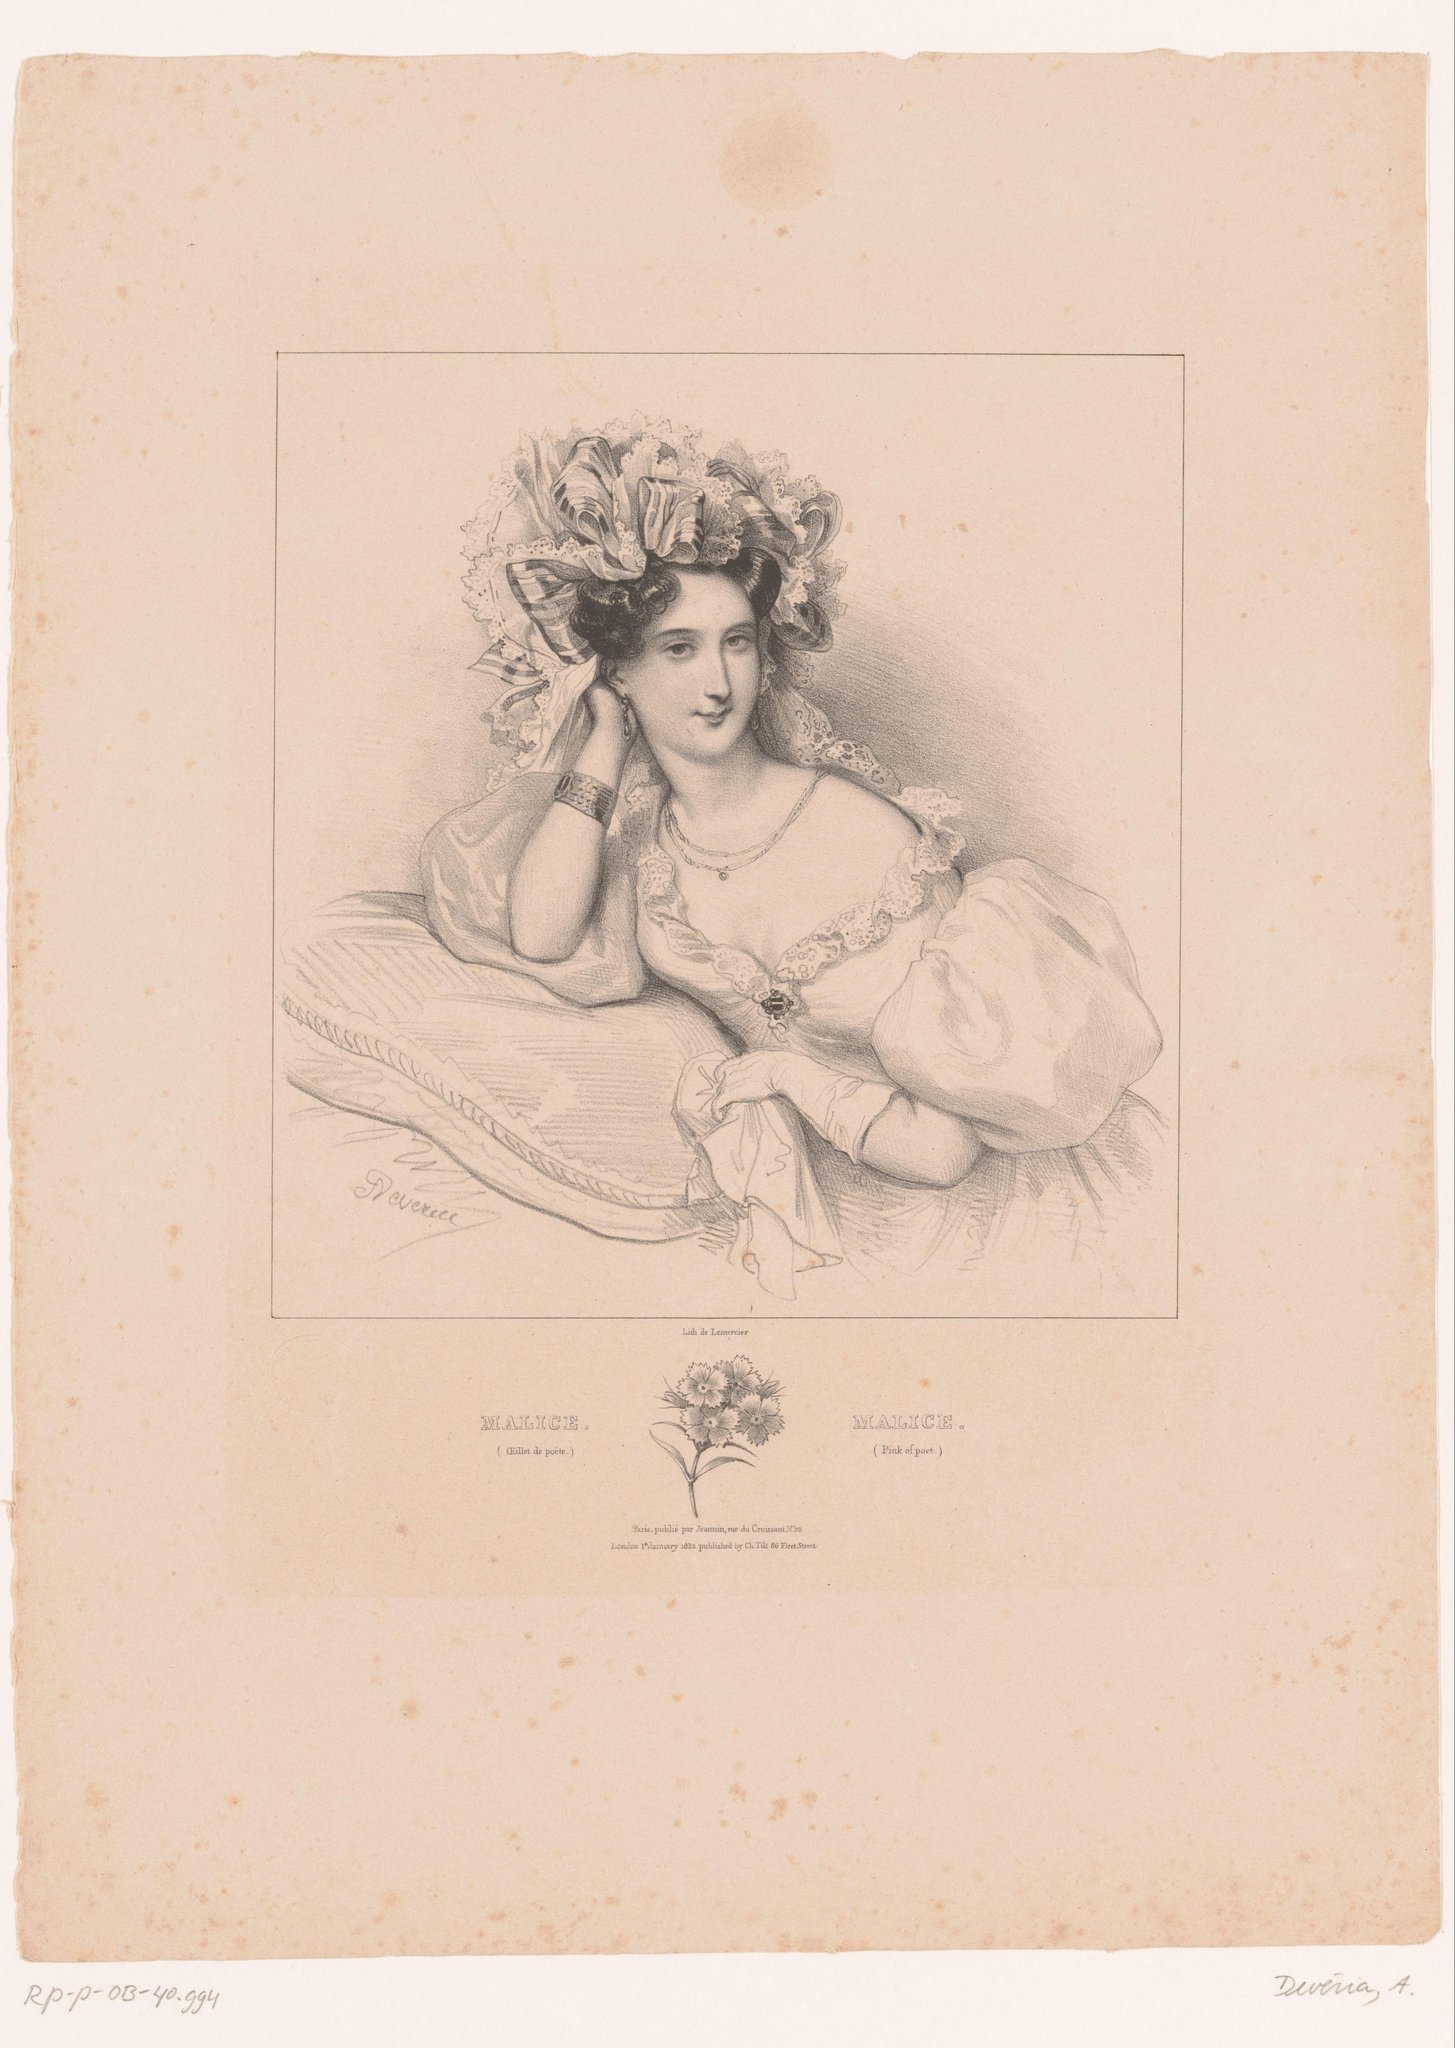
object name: print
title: Taal der bloemen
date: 1831-1832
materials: paper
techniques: lithograph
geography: paris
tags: flowers, adolescent, young woman, maiden, malevolence, maliciousness; 'malevolenza', 'malignità', 'malvagità' (ripa)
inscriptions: check stamp: Lugt 3987